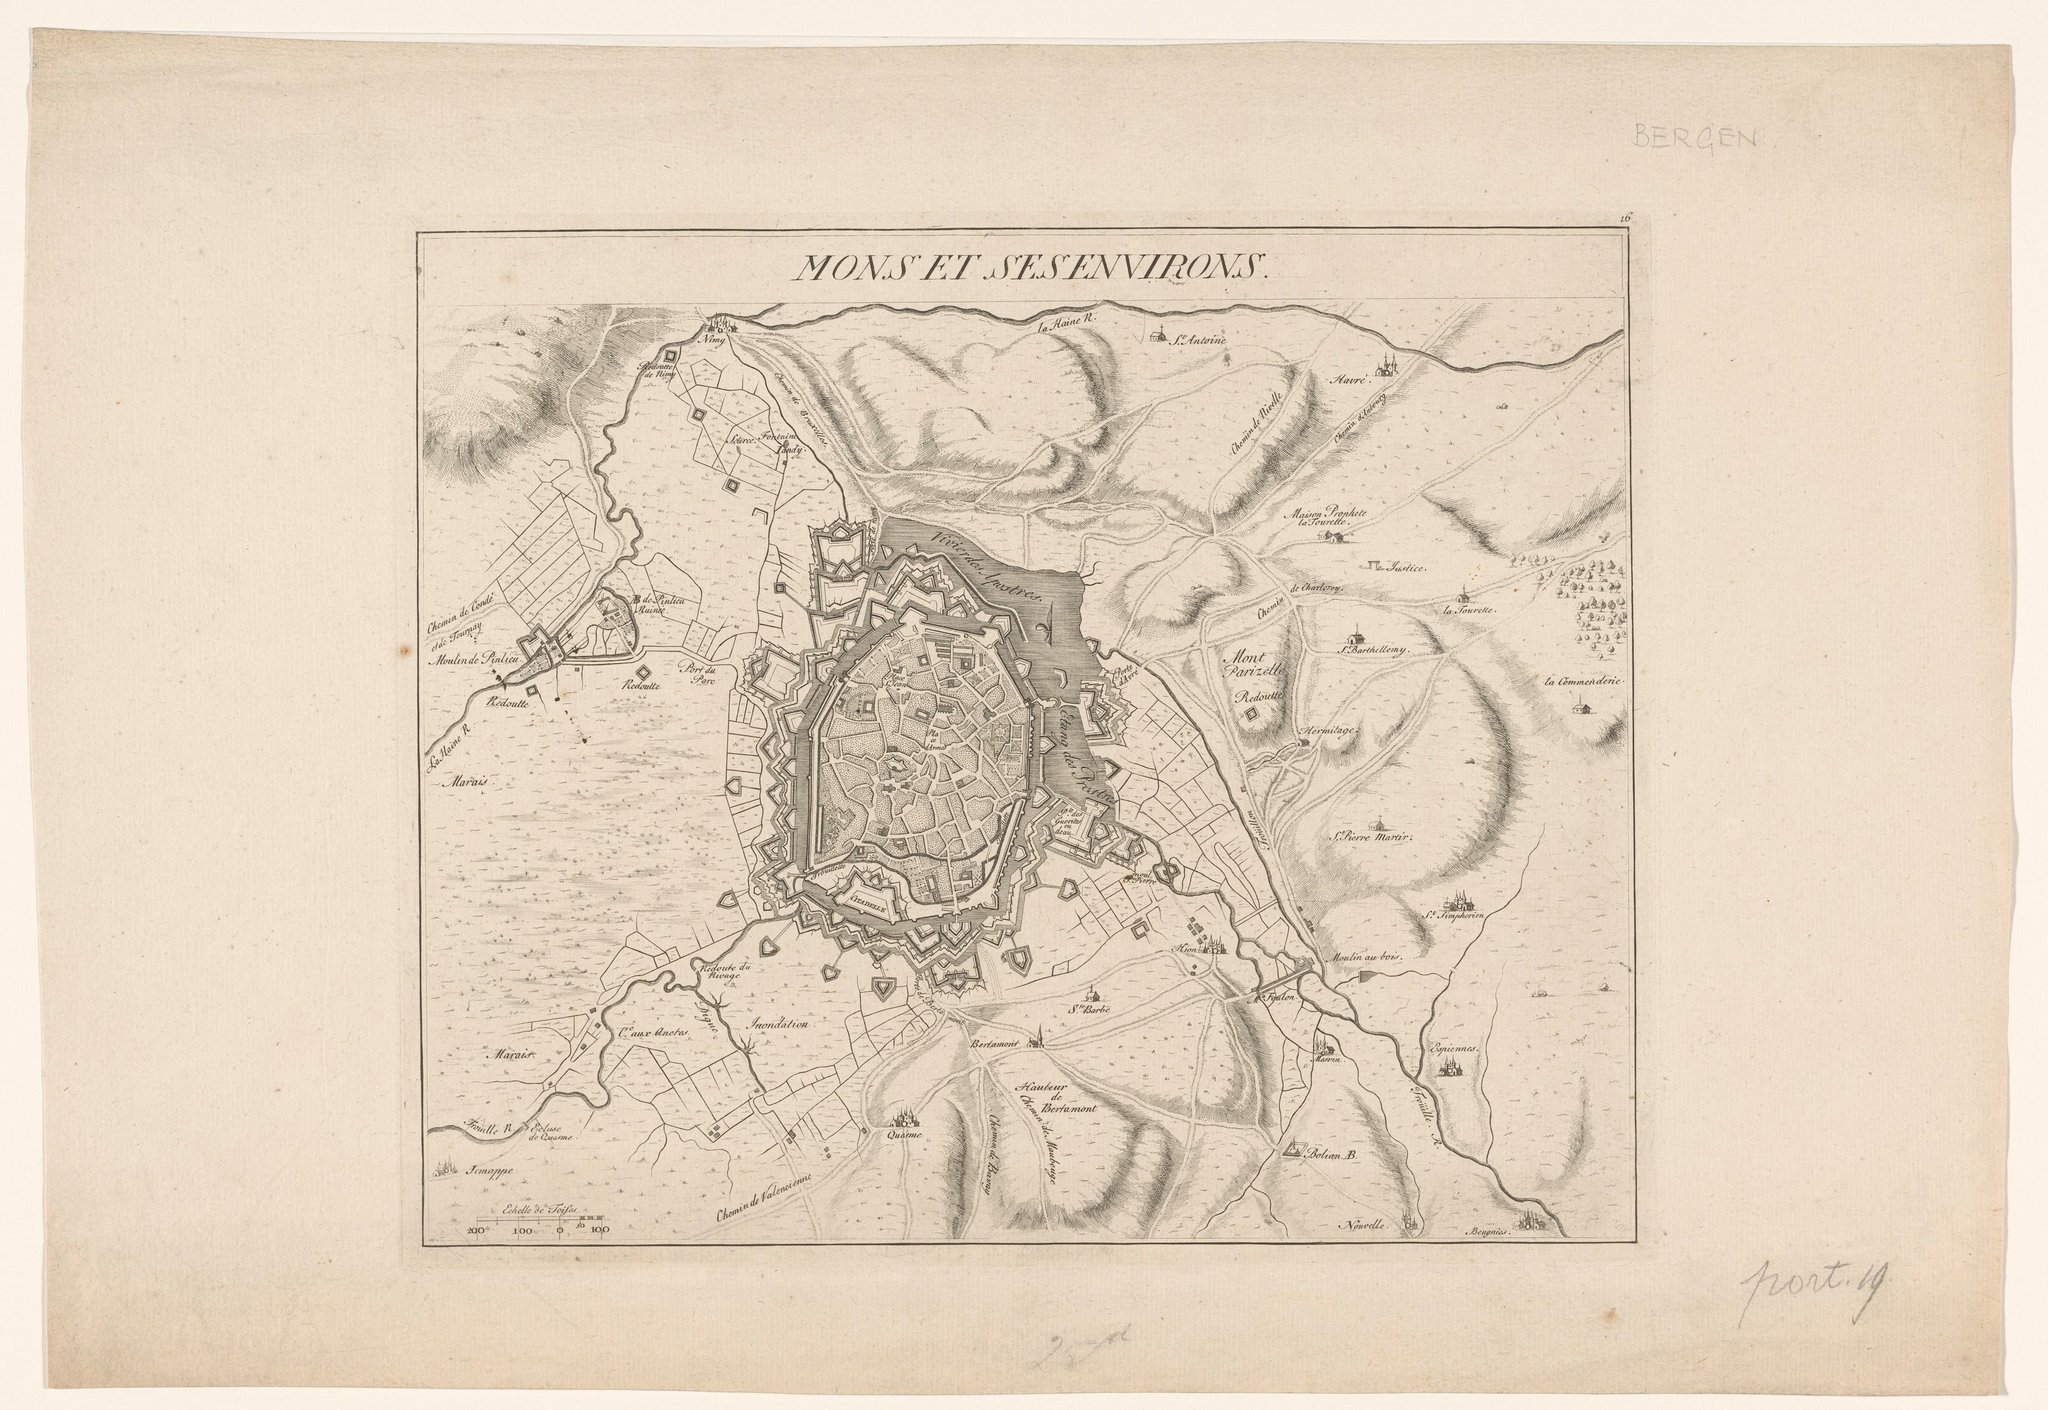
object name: area plan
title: Mons et ses environs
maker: Anonymous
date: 1650-1750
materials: paper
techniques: engraving, etching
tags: siege, position war, maps of cities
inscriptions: collector's mark: Lugt 2228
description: Plattegrond van Bergen (Mons). In een balk boven de plattegrond de titel. Linksonder een schaalstok: Echelle de Toises. Rechtsboven genummerd: 16.